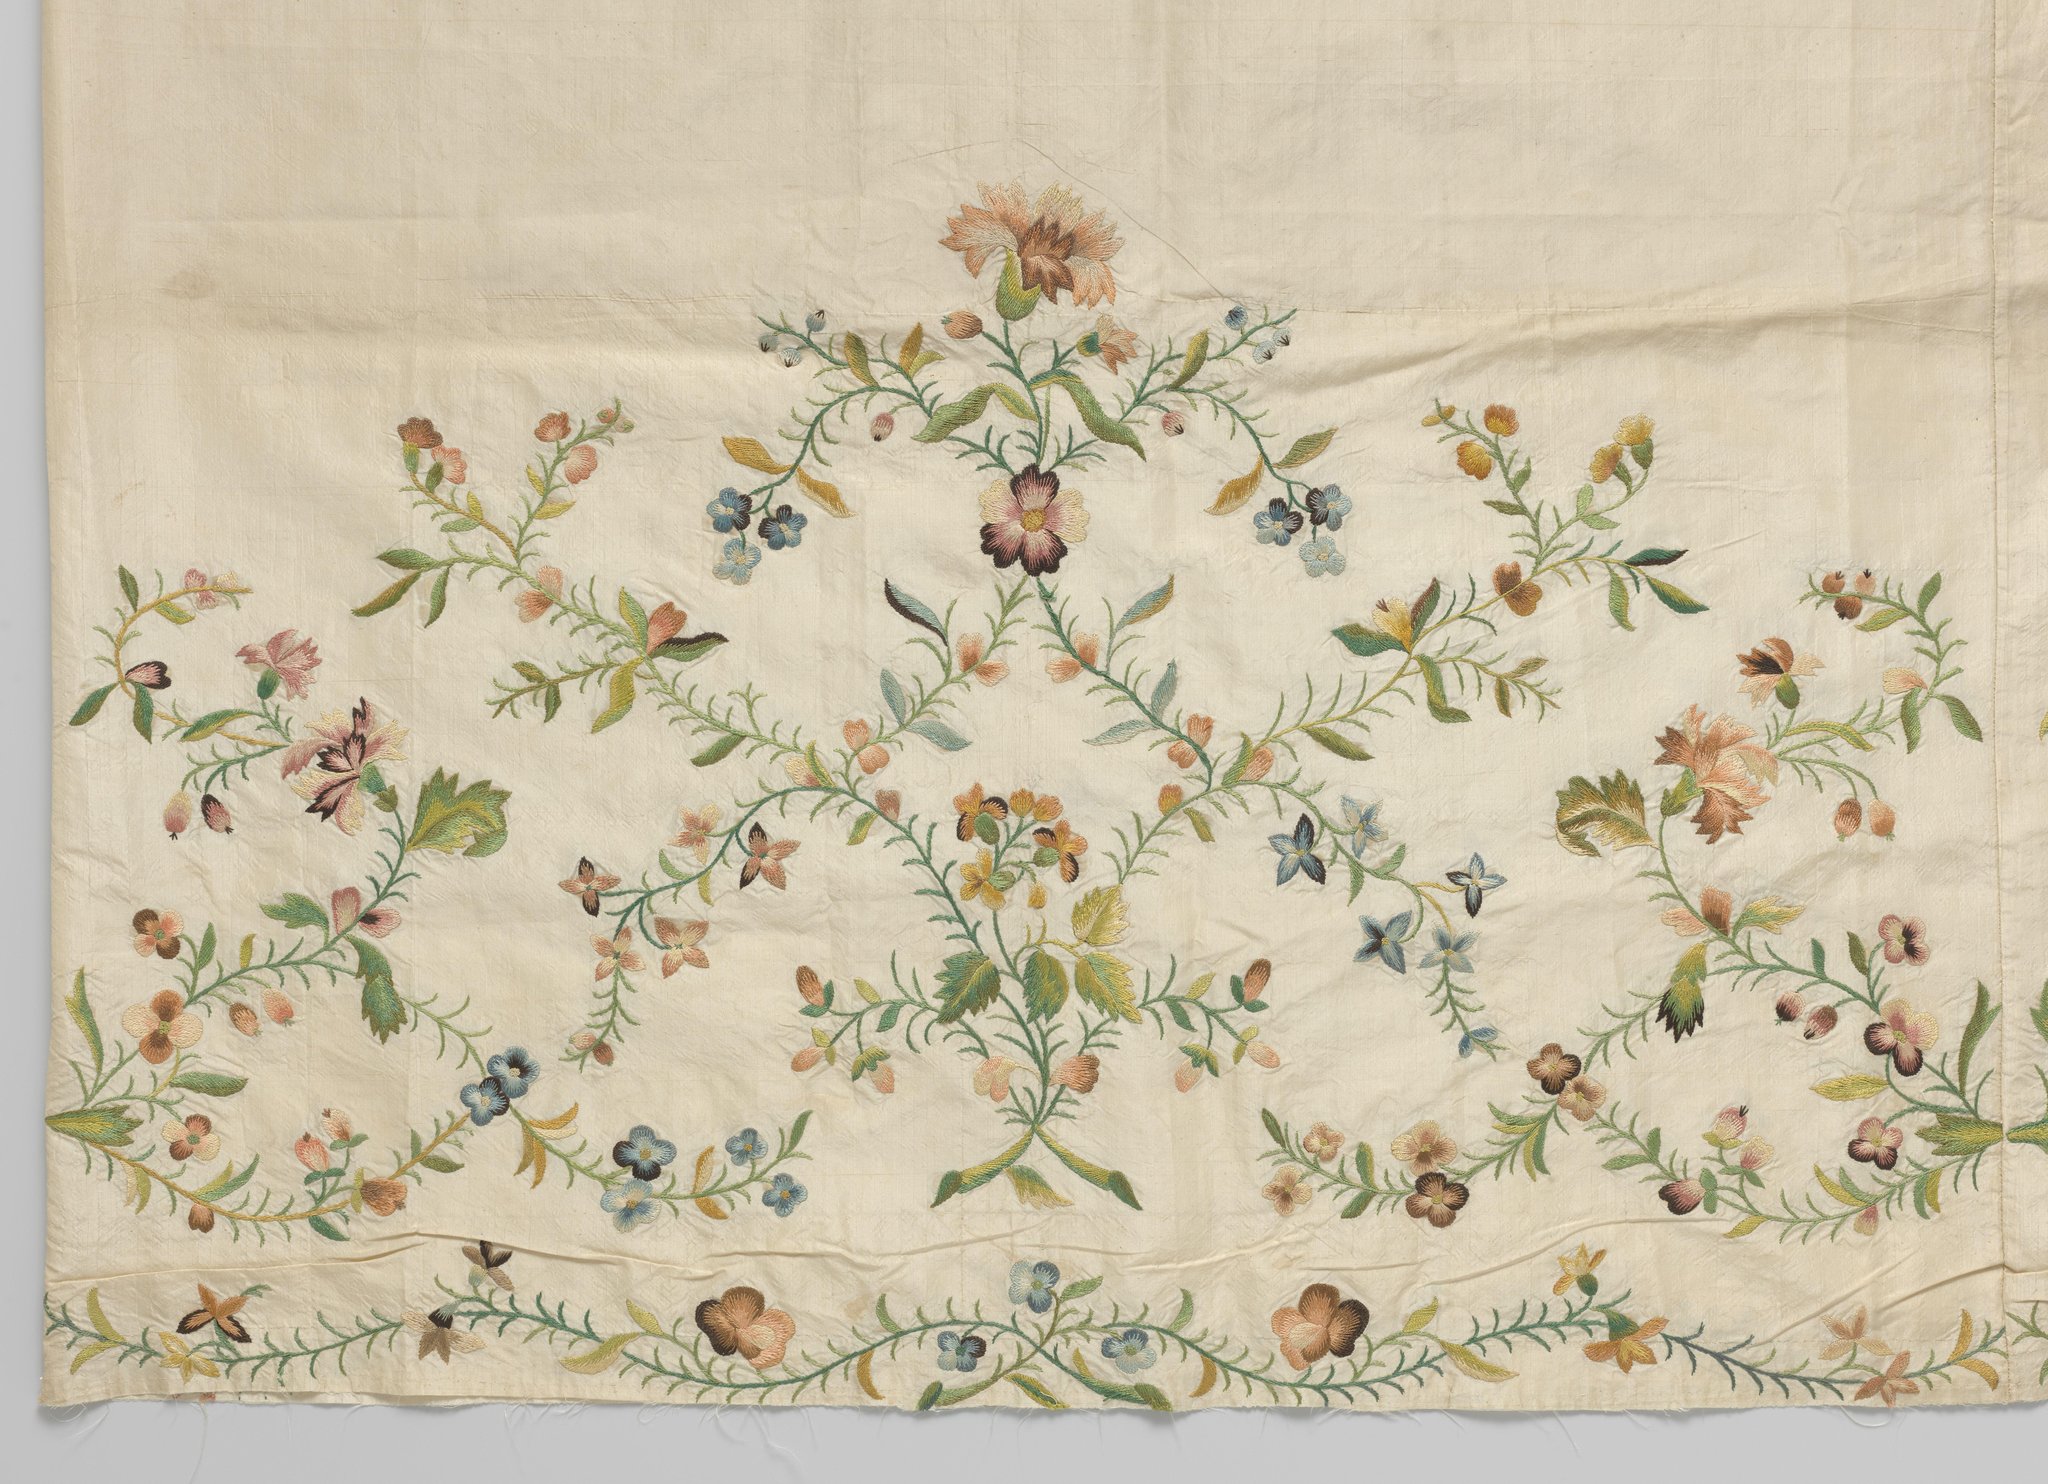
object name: womenswear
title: Rokpanden van witte tafzijde, onderaan versierd geborduurde bloemenranken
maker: Anonymous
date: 1750-1800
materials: silk, textile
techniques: embroidered, sewing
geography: netherlands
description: Zijde voor een dames rok , E.A., en zijden voeringen. Twee 18de eeuwse, nog aan elkaar genaaide rokpanden van witte tafzijde, onderaan met brede borduurrand vanslingerende en kruisende ranken met genuanceerde bloemen, in fletse kleuren, o.a. met anjer in top; nog erbij een afgeronde pas v.e. tas(?). Toestand: Zal vermoedelijk door wassen erg verbleekt zijn tot veel vuil bruin/beige.